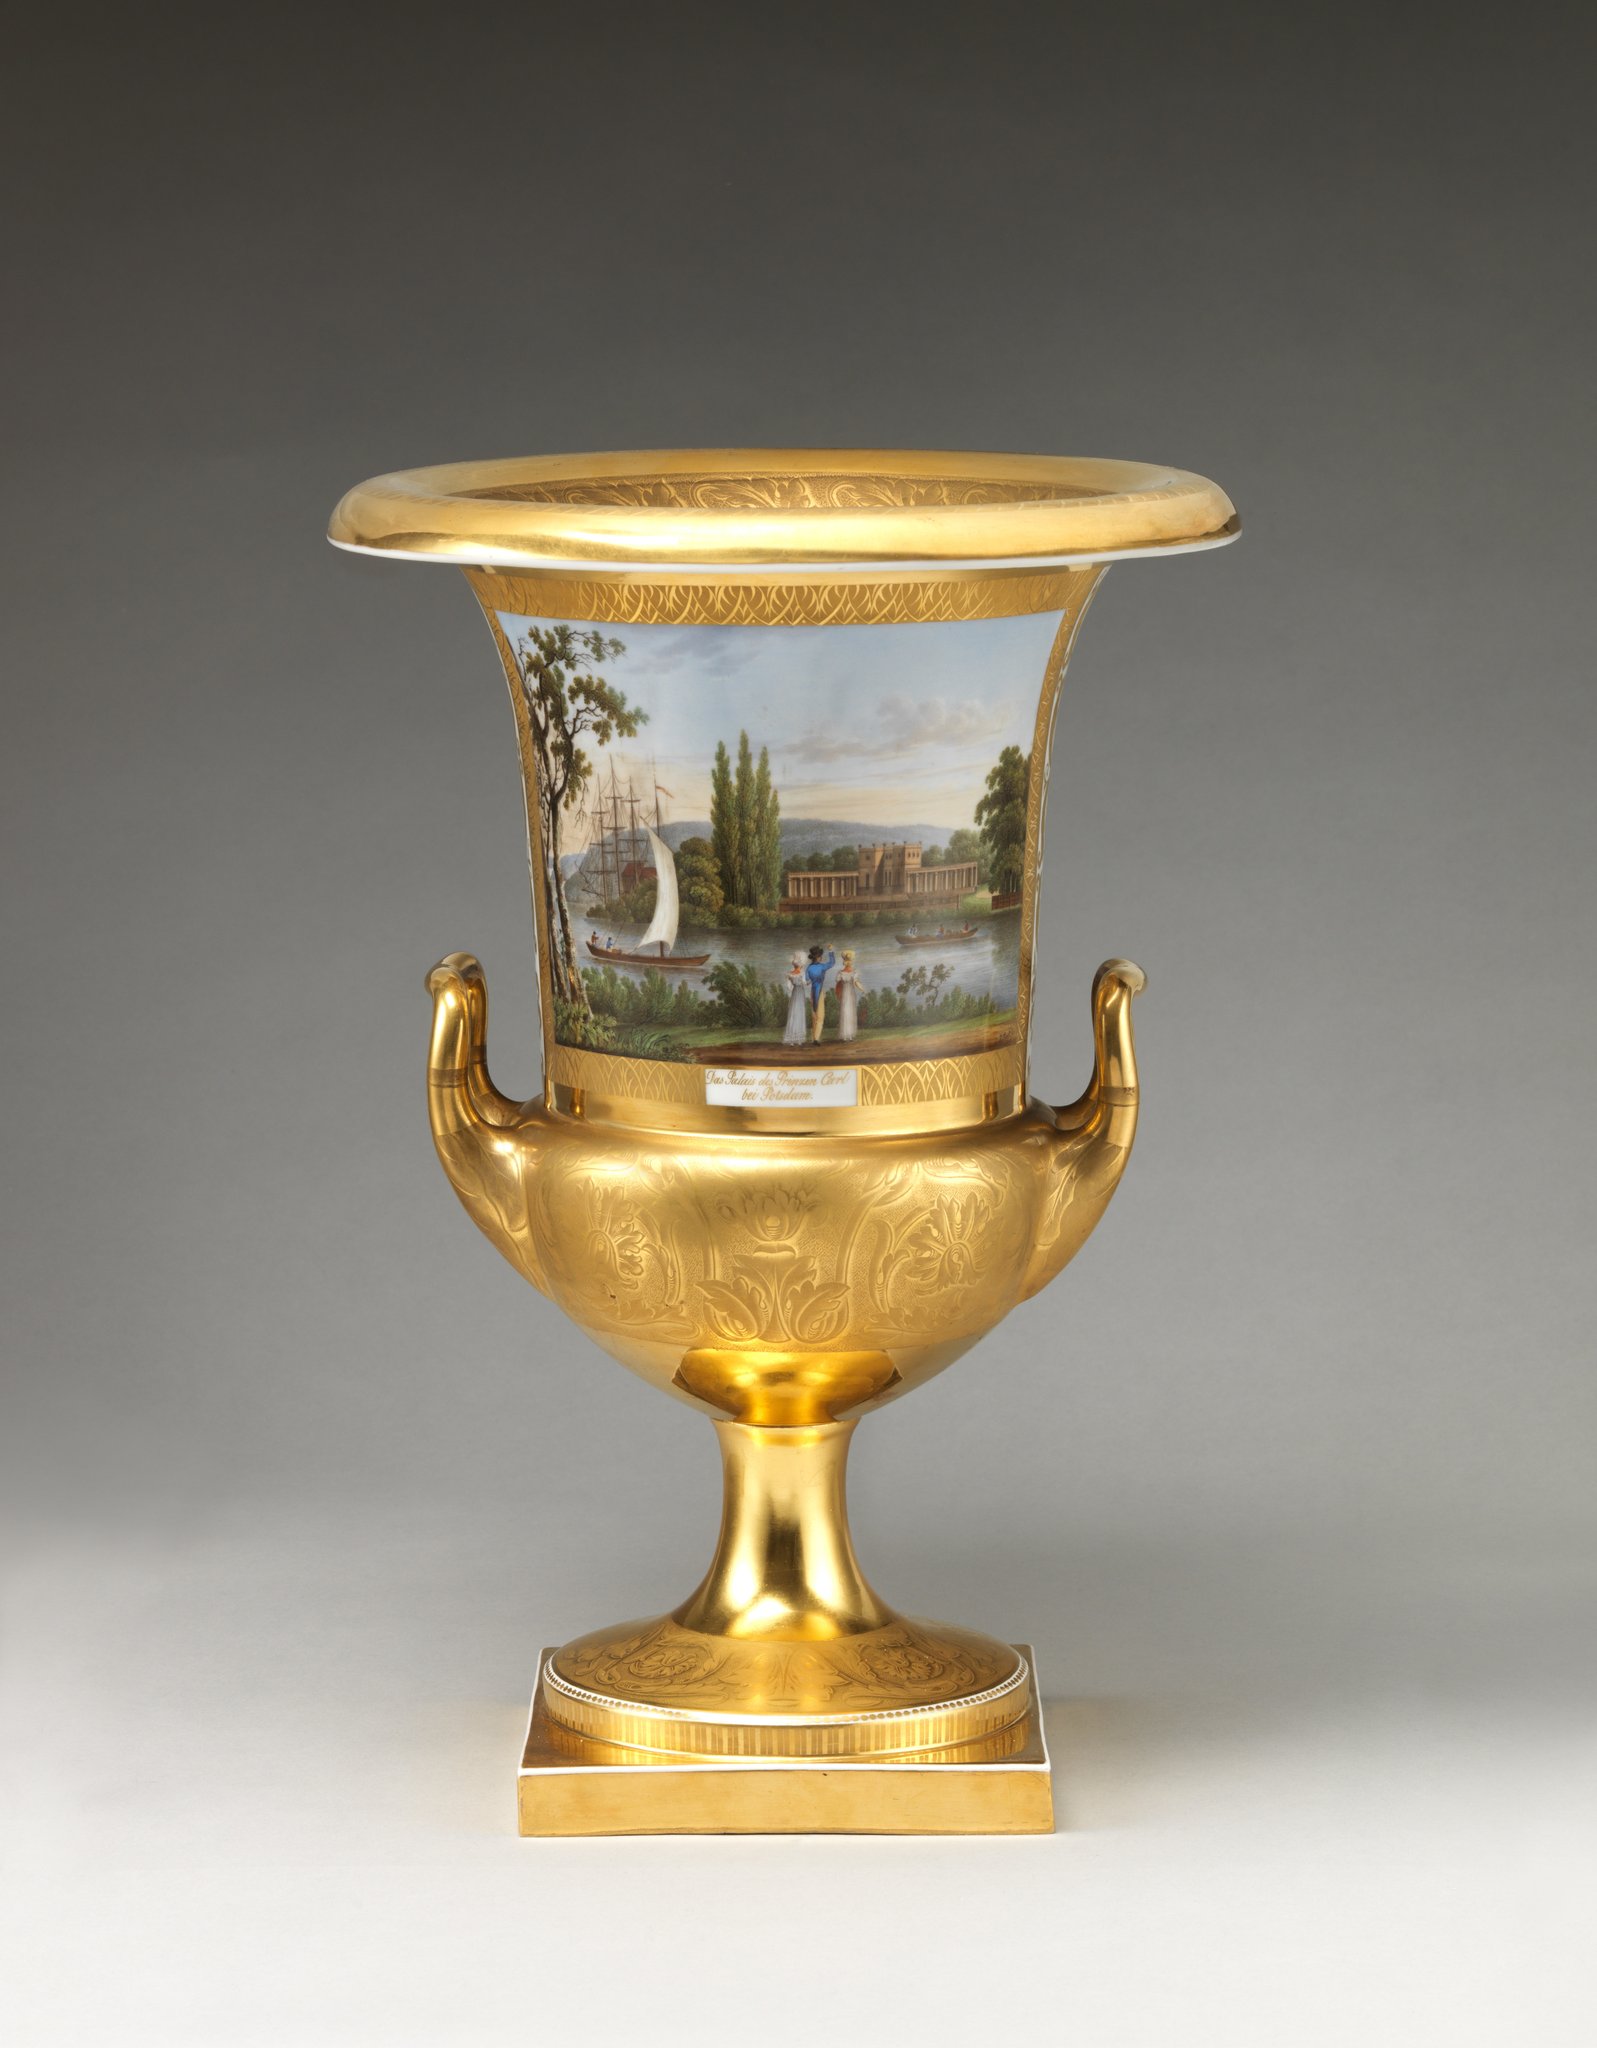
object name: vase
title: Krater vase with a signed view of Potsdam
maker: royal porcelain manufactory (königliche porzellan-manufaktur), berlin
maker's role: manufactory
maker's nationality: german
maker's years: 1763-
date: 1825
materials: hard paste porcelain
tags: palaces,boats